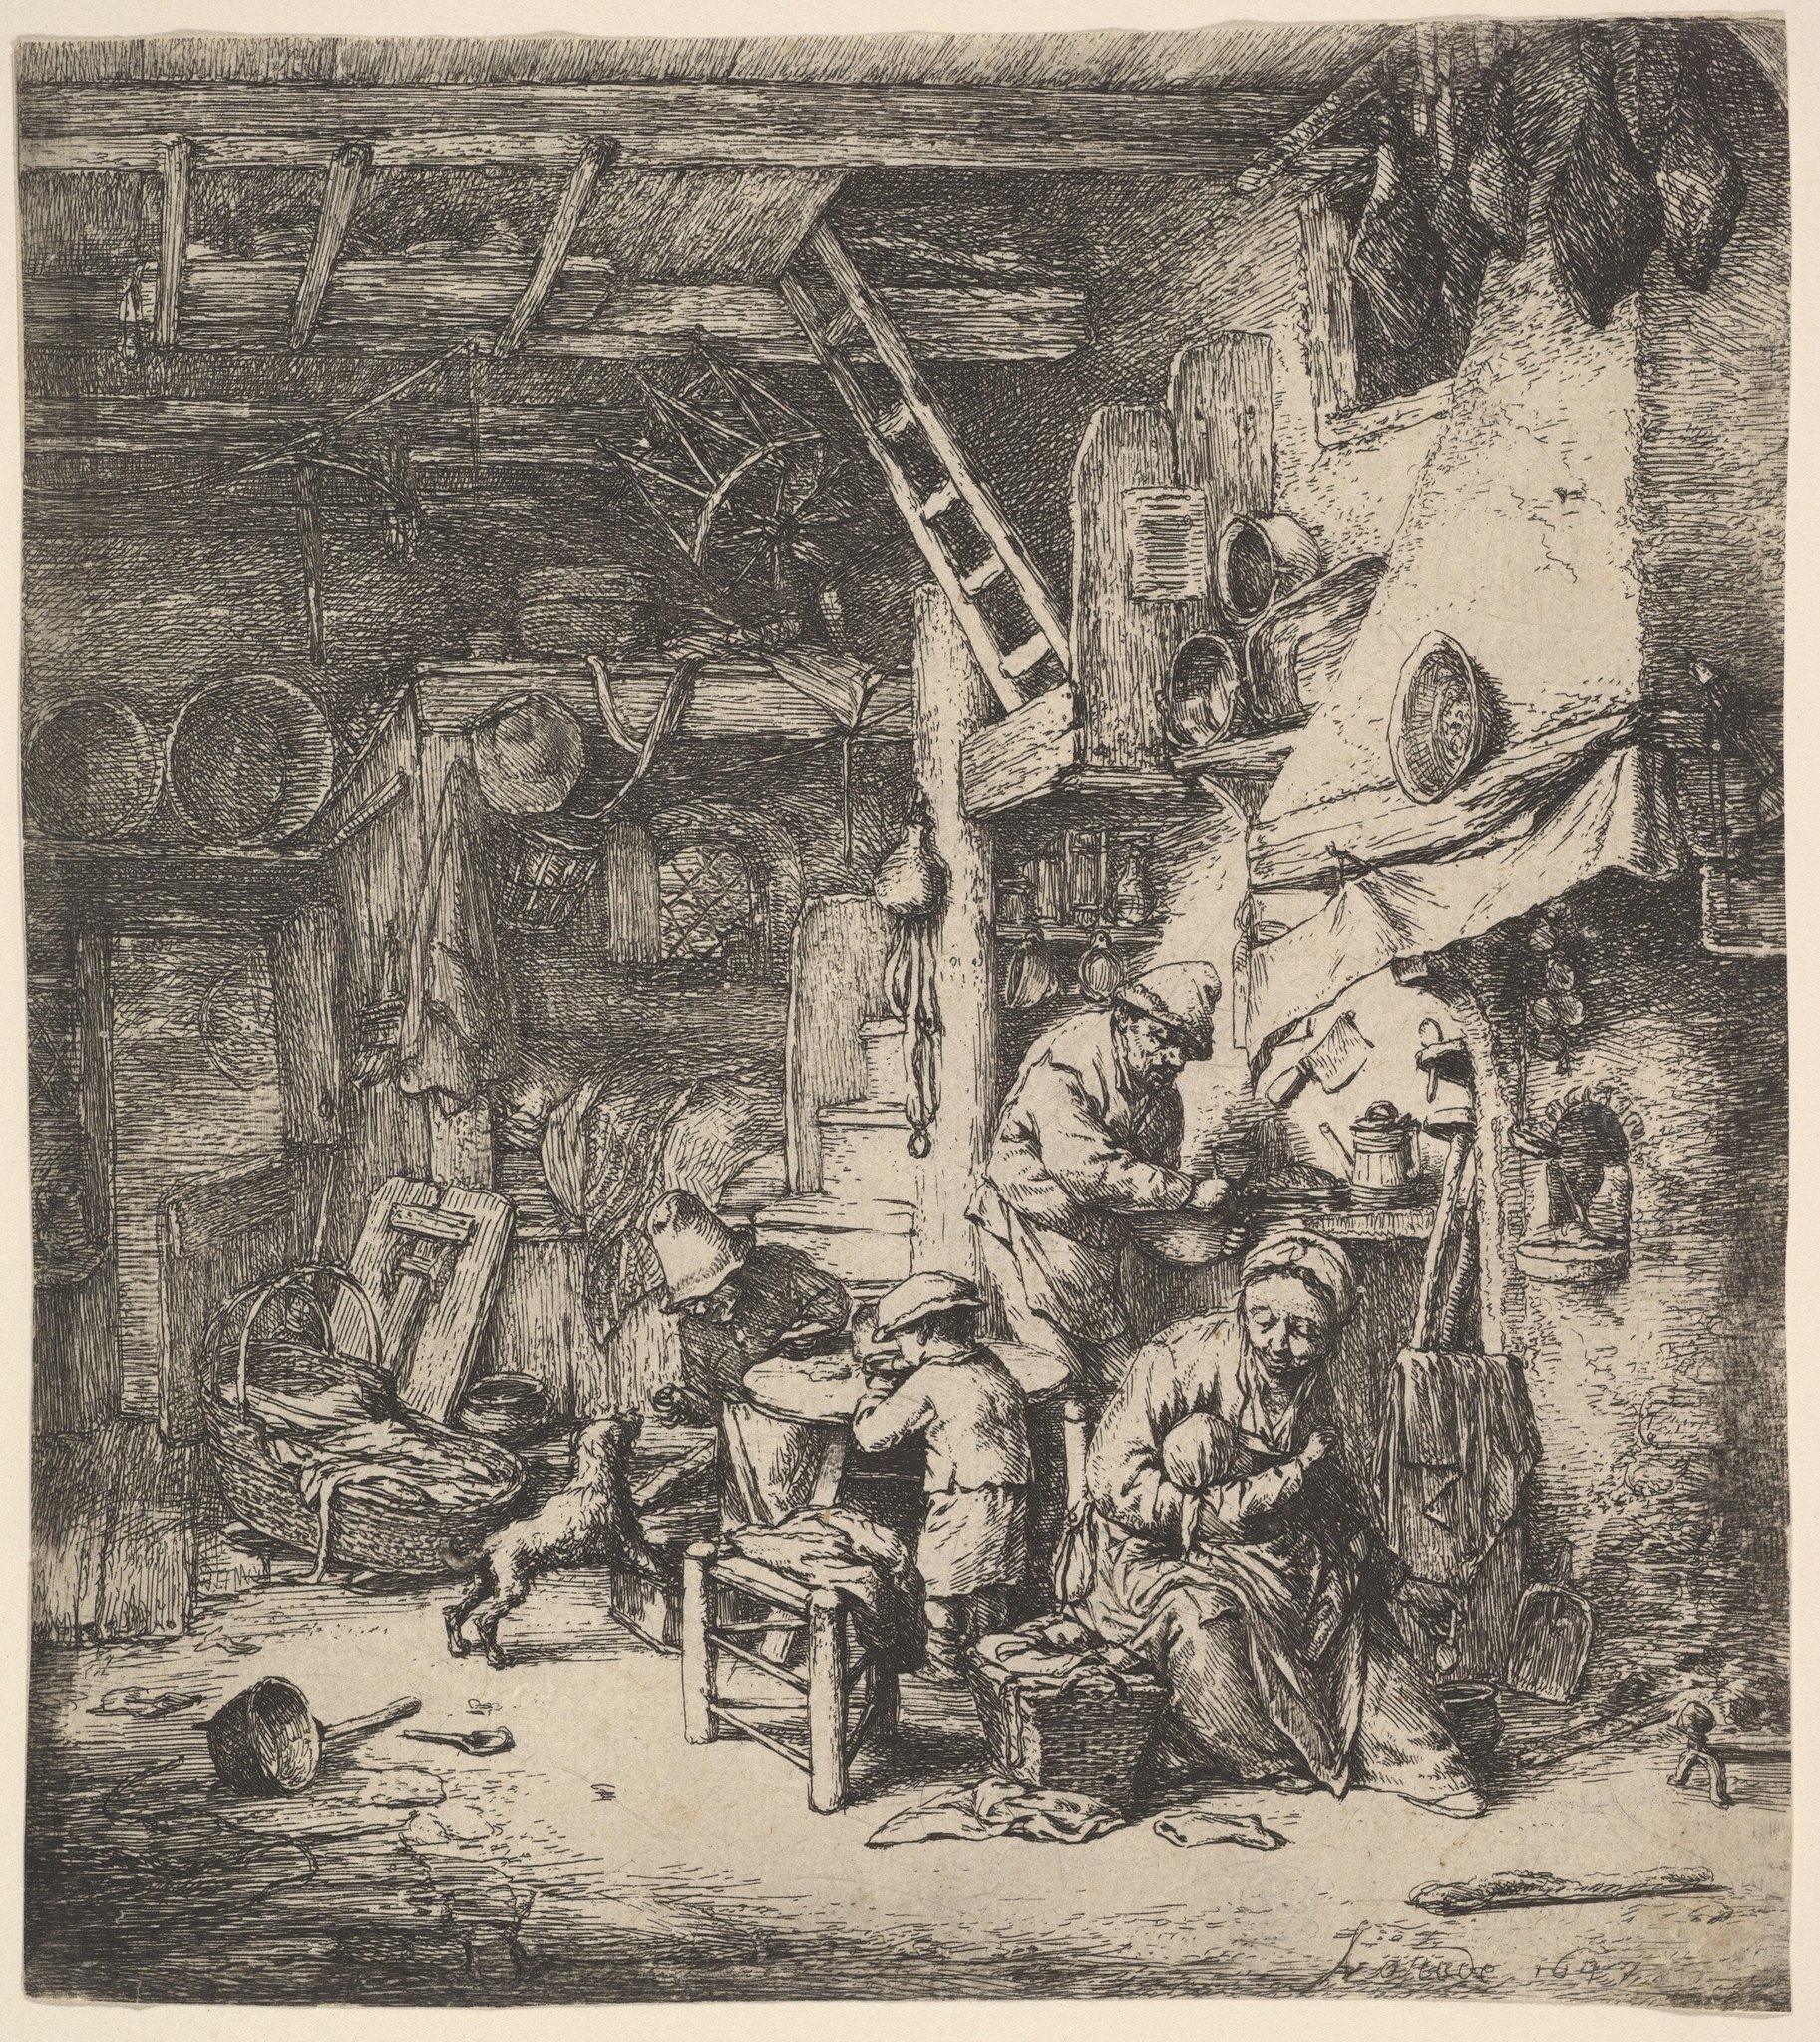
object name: print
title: The Family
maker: adriaen van ostade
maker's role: artist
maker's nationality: dutch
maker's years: 1610-1685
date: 1647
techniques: etching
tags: interiors,children,men,women,dogs,daily life,family